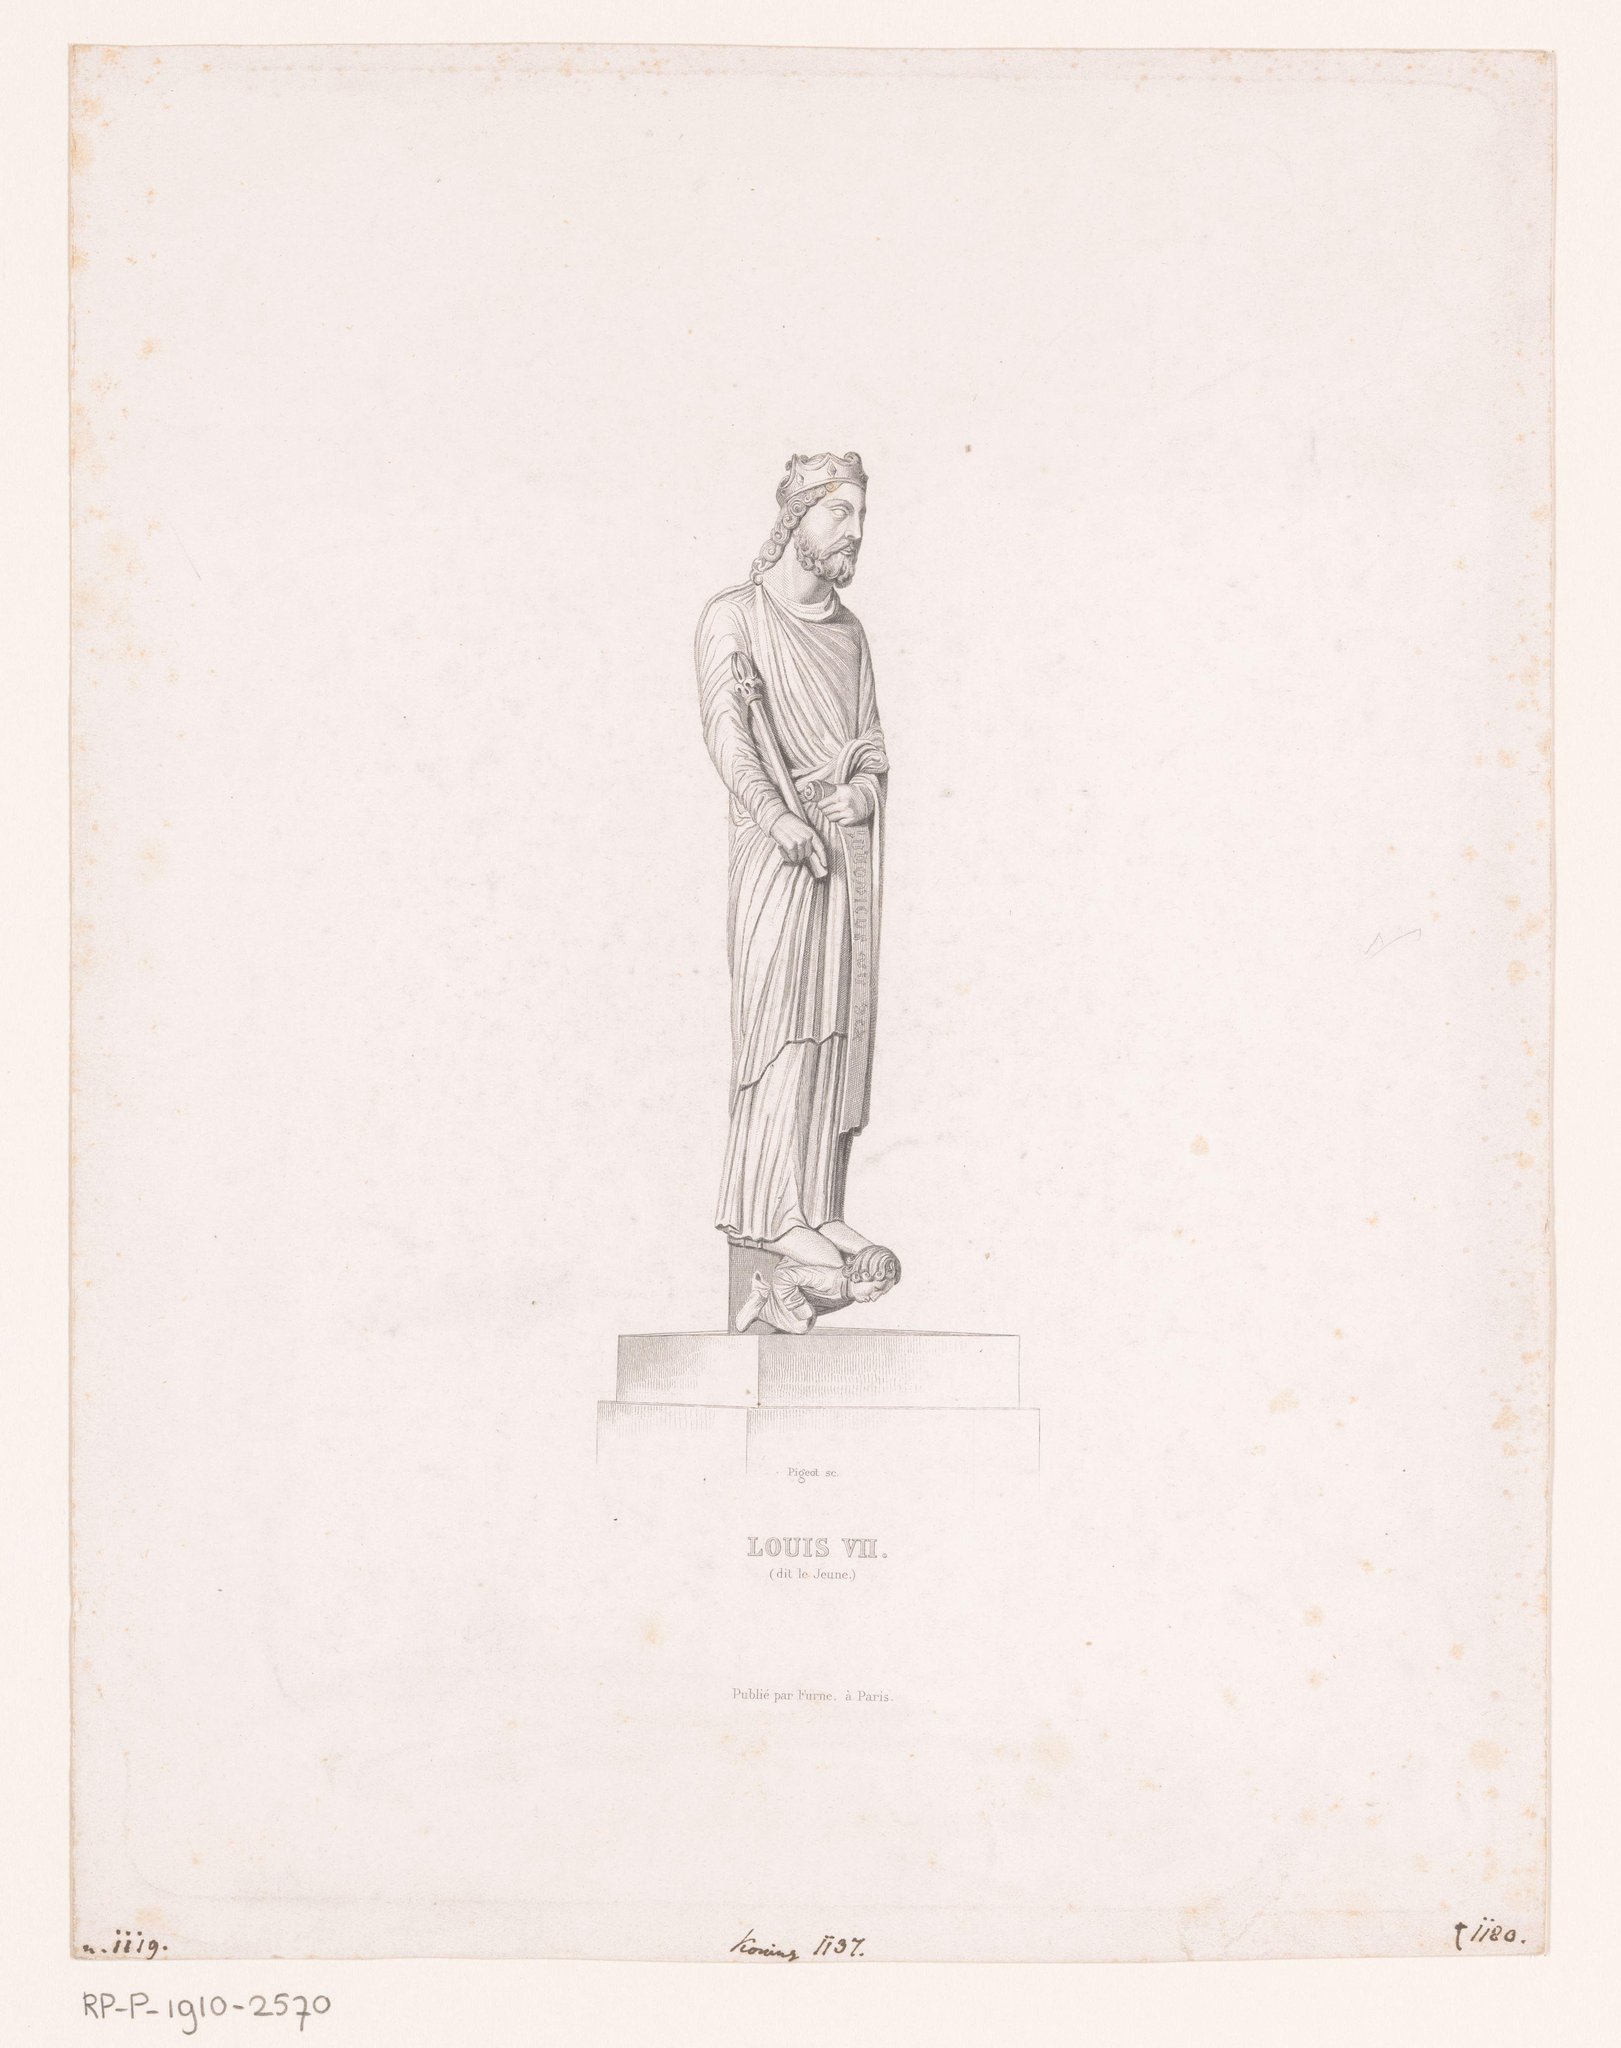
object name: print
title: Standbeeld van koning Lodewijk VII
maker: charles furne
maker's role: publisher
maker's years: 1794-1859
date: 1785-1874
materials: paper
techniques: etching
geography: paris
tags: paris, historical persons, monument, statue, king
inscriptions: collector's mark: Lugt 2228